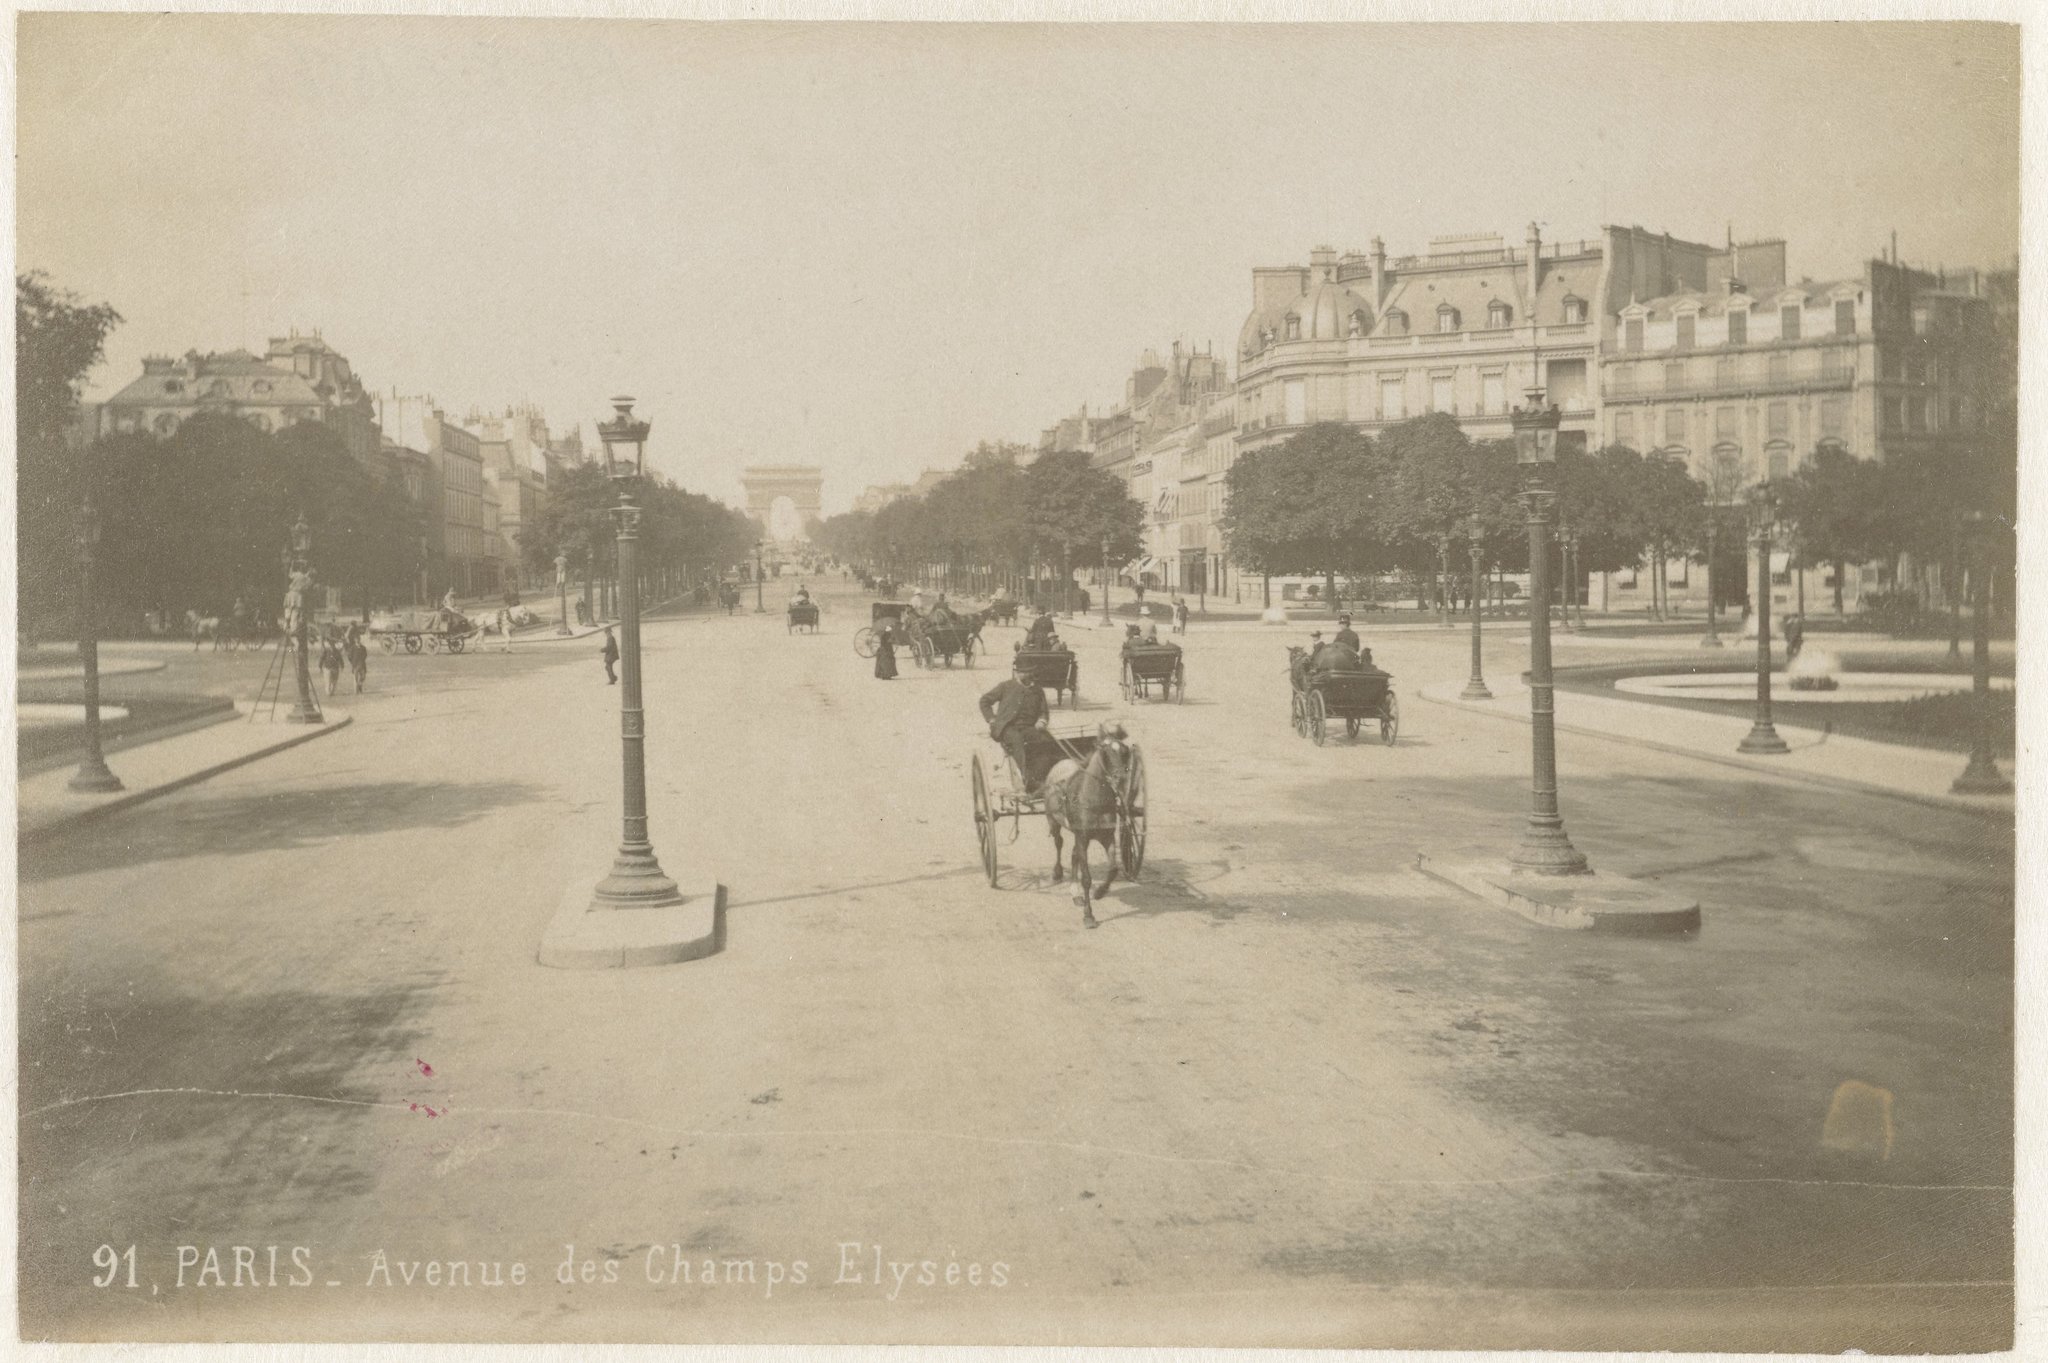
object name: photograph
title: Gezicht op de Champs-Elysées in Parijs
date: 1850-1900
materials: paper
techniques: albumen print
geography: paris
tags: street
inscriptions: address: ‘Jules HAUTECOEUR,/ PARIS,/ 172, Rue de Rivoli.’, number: ‘91.’